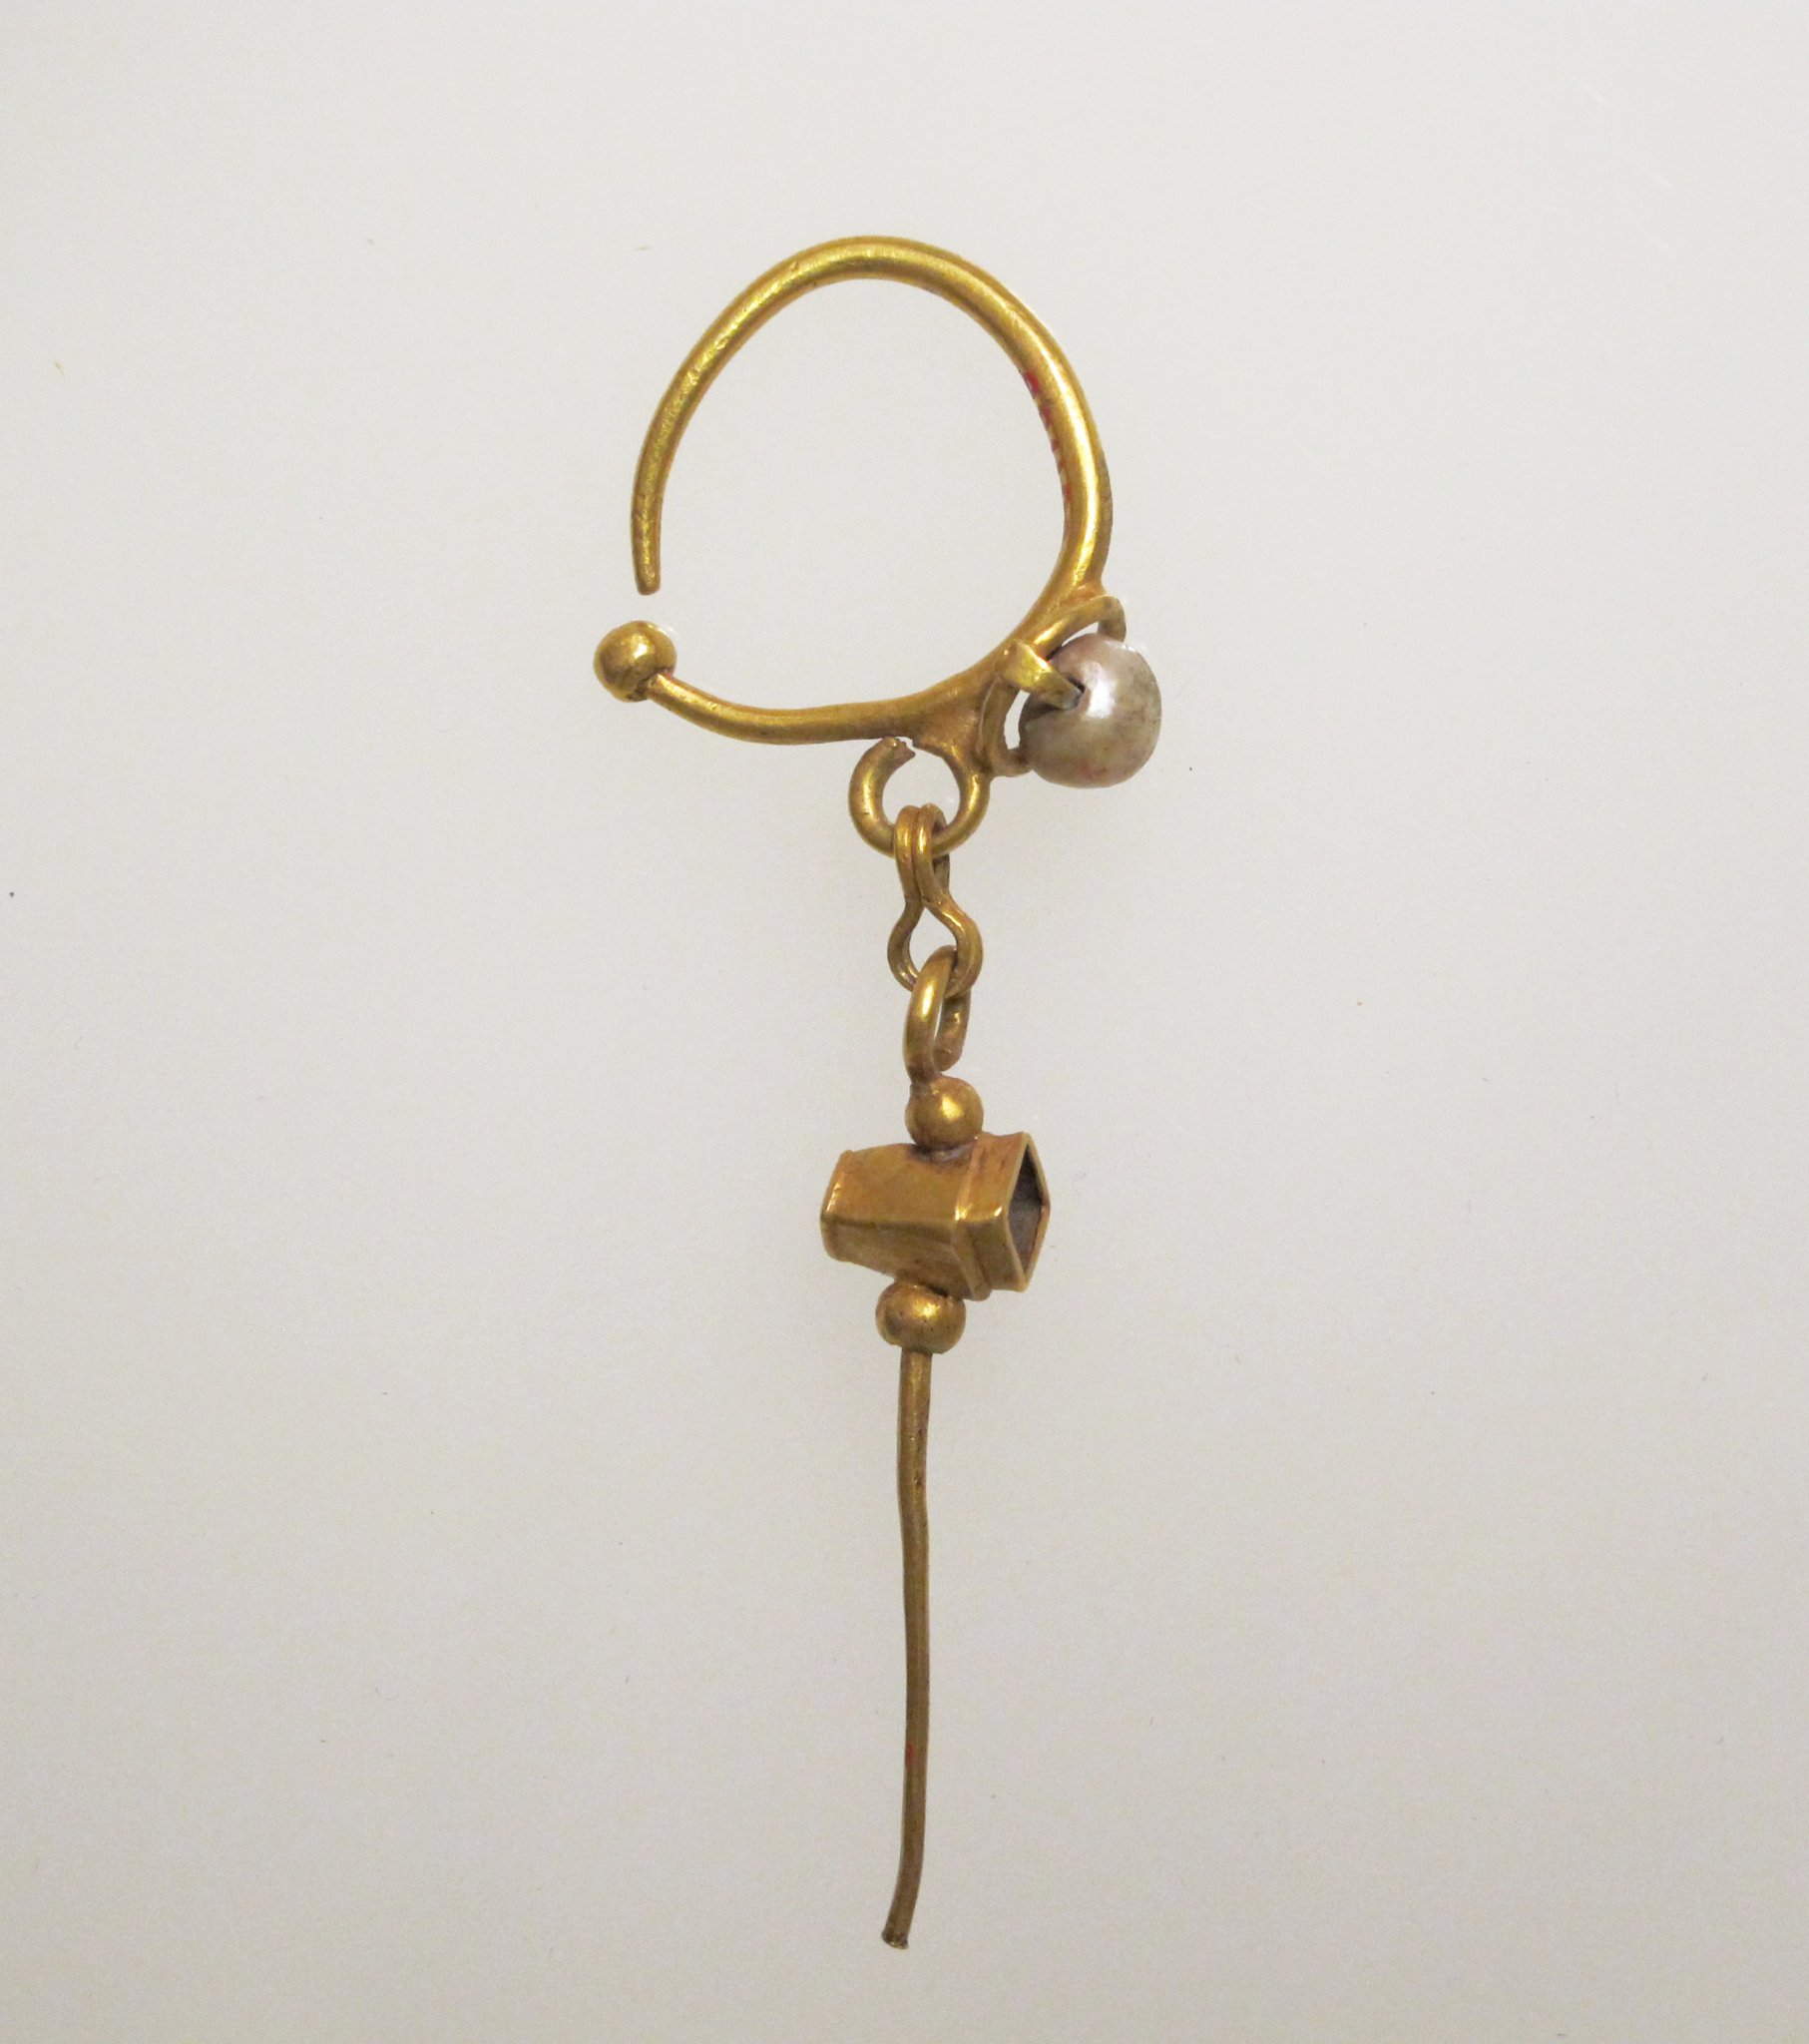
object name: earring with pendant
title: Earring with pendant and pearl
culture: roman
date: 670 BCE-330 CE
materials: gold, pearl